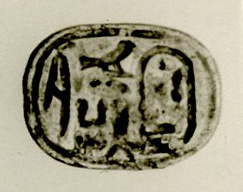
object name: scarab, akhenaten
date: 1353-1336 BCE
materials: stone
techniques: glazing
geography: egypt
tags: hieroglyphs,scarabs